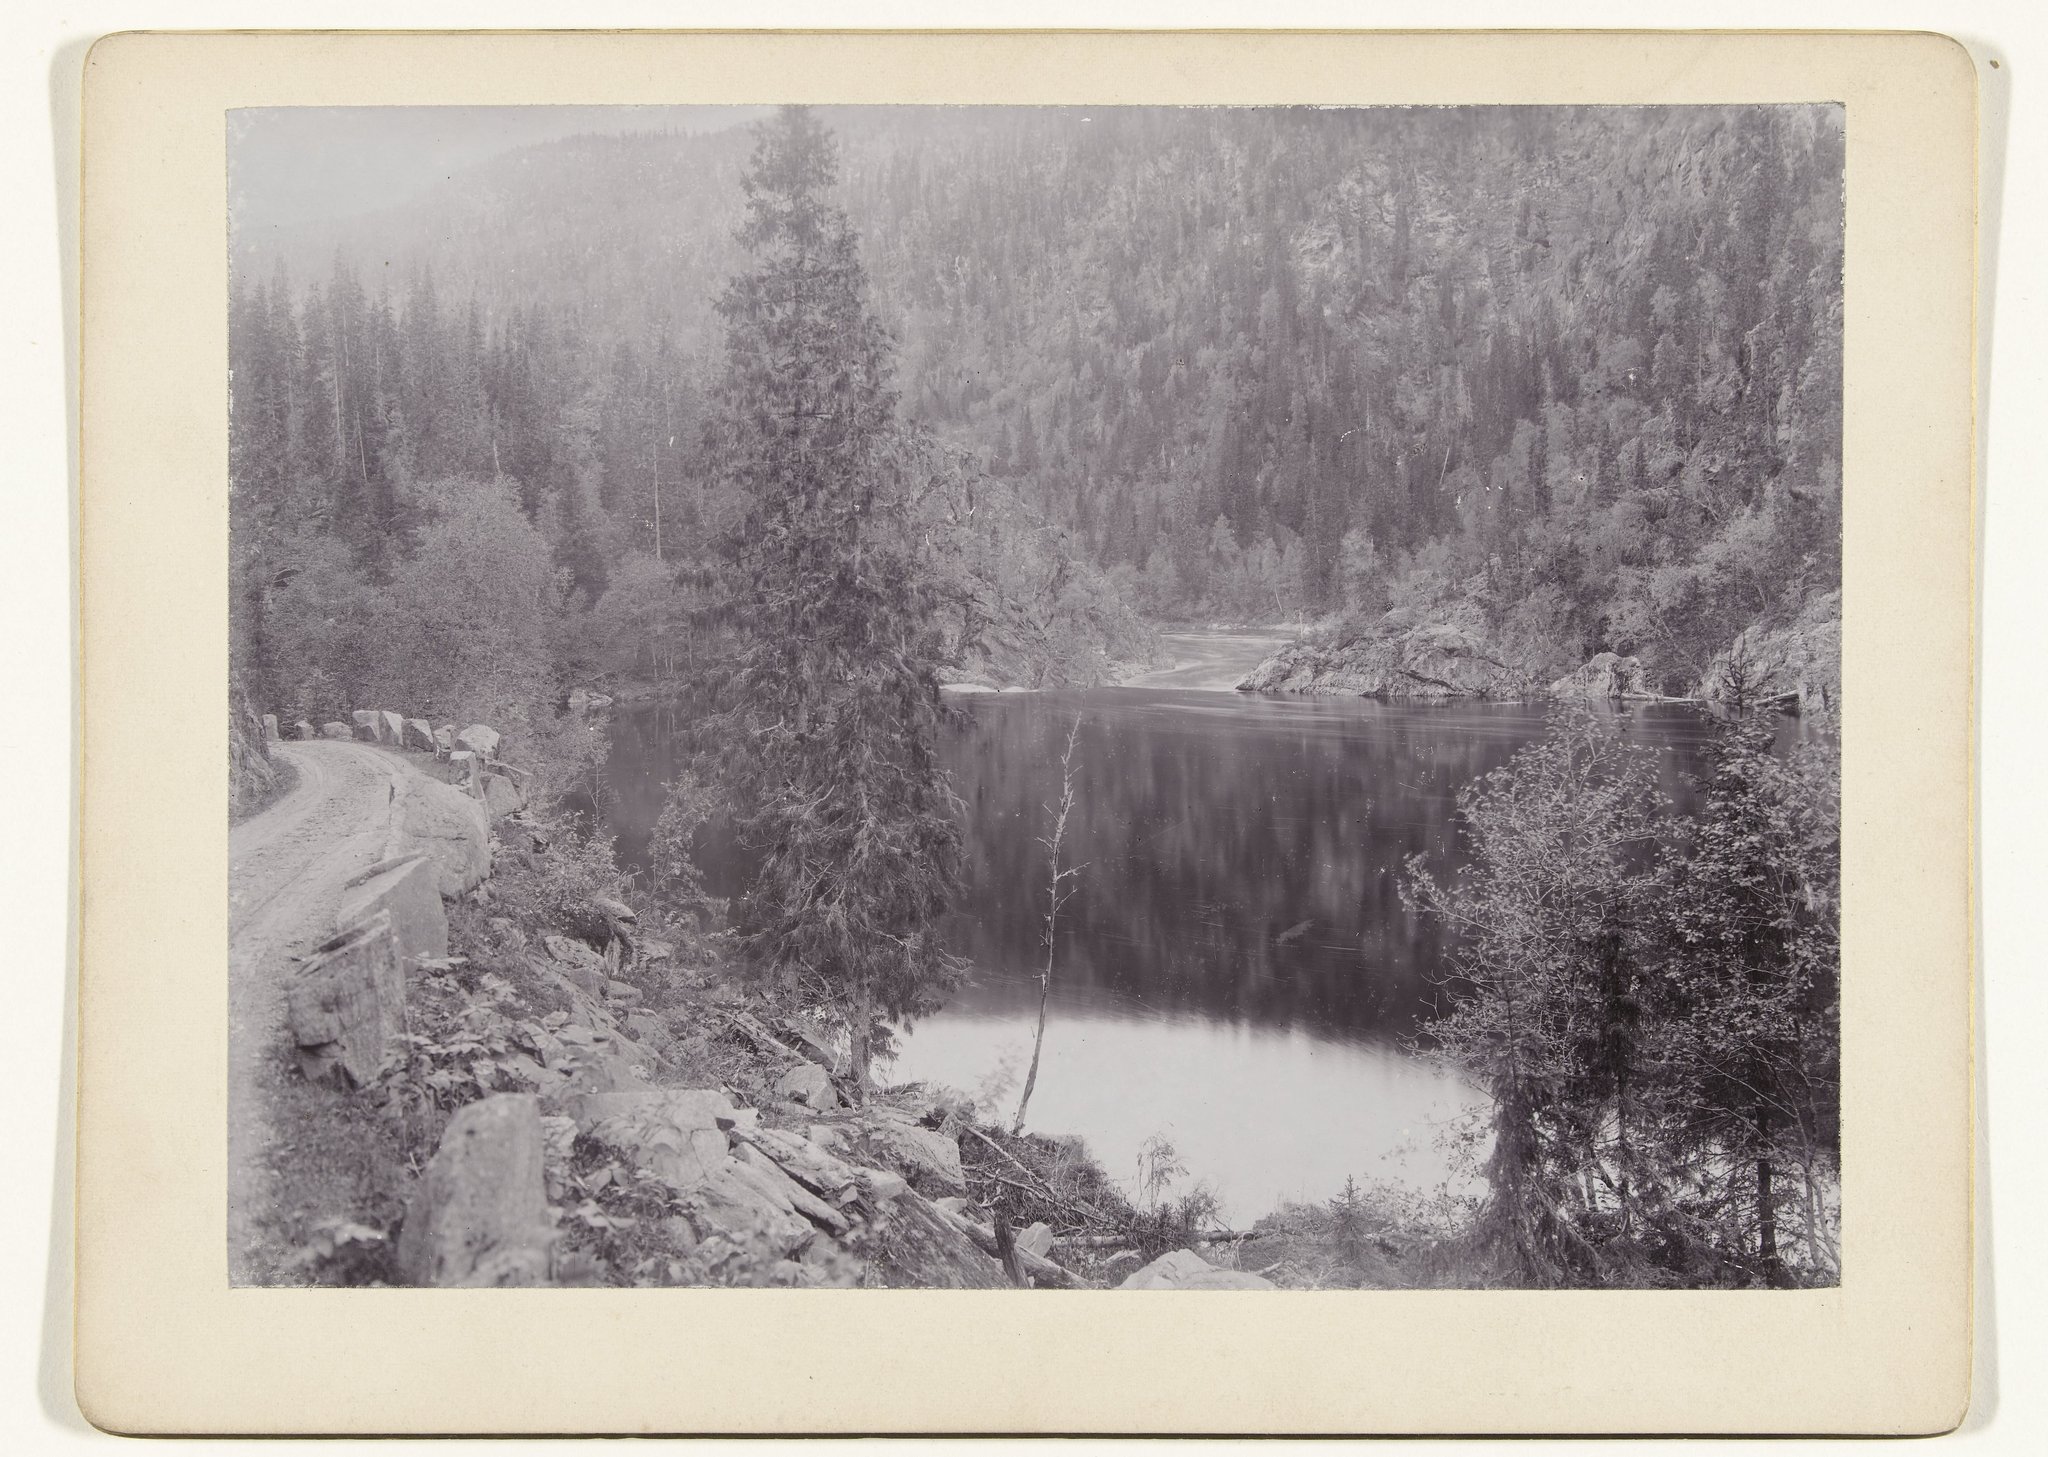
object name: photograph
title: Gezicht op een meer in een berglandschap (Noorwegen?)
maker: henry pauw van wieldrecht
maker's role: fotograaf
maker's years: 1863-1912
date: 1900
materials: cardboard, photographic support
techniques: gelatin silver print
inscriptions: annotation: ‘No 1856. / 1900.’